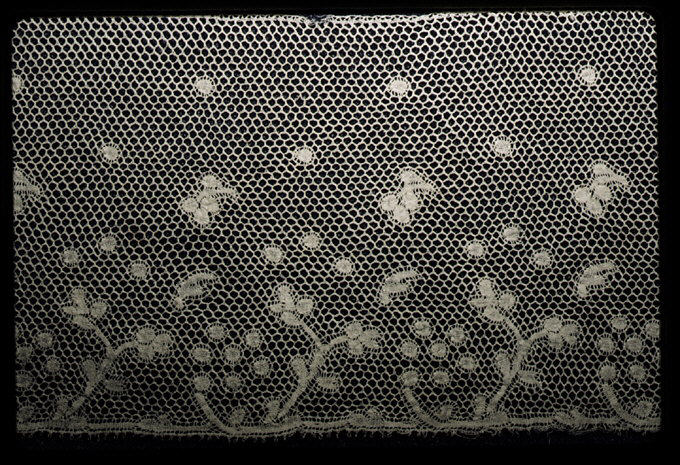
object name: border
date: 1701-1800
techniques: lace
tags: flowers